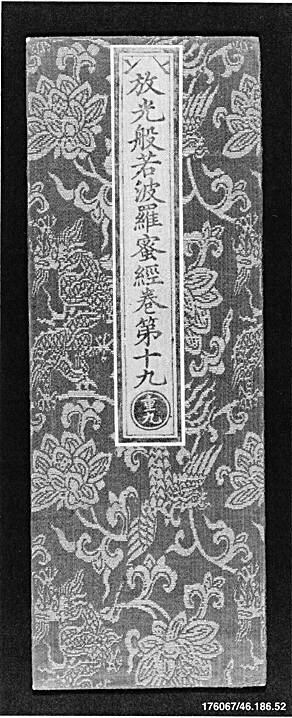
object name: sutra cover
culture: chinese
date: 1501-1600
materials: silk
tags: flowers